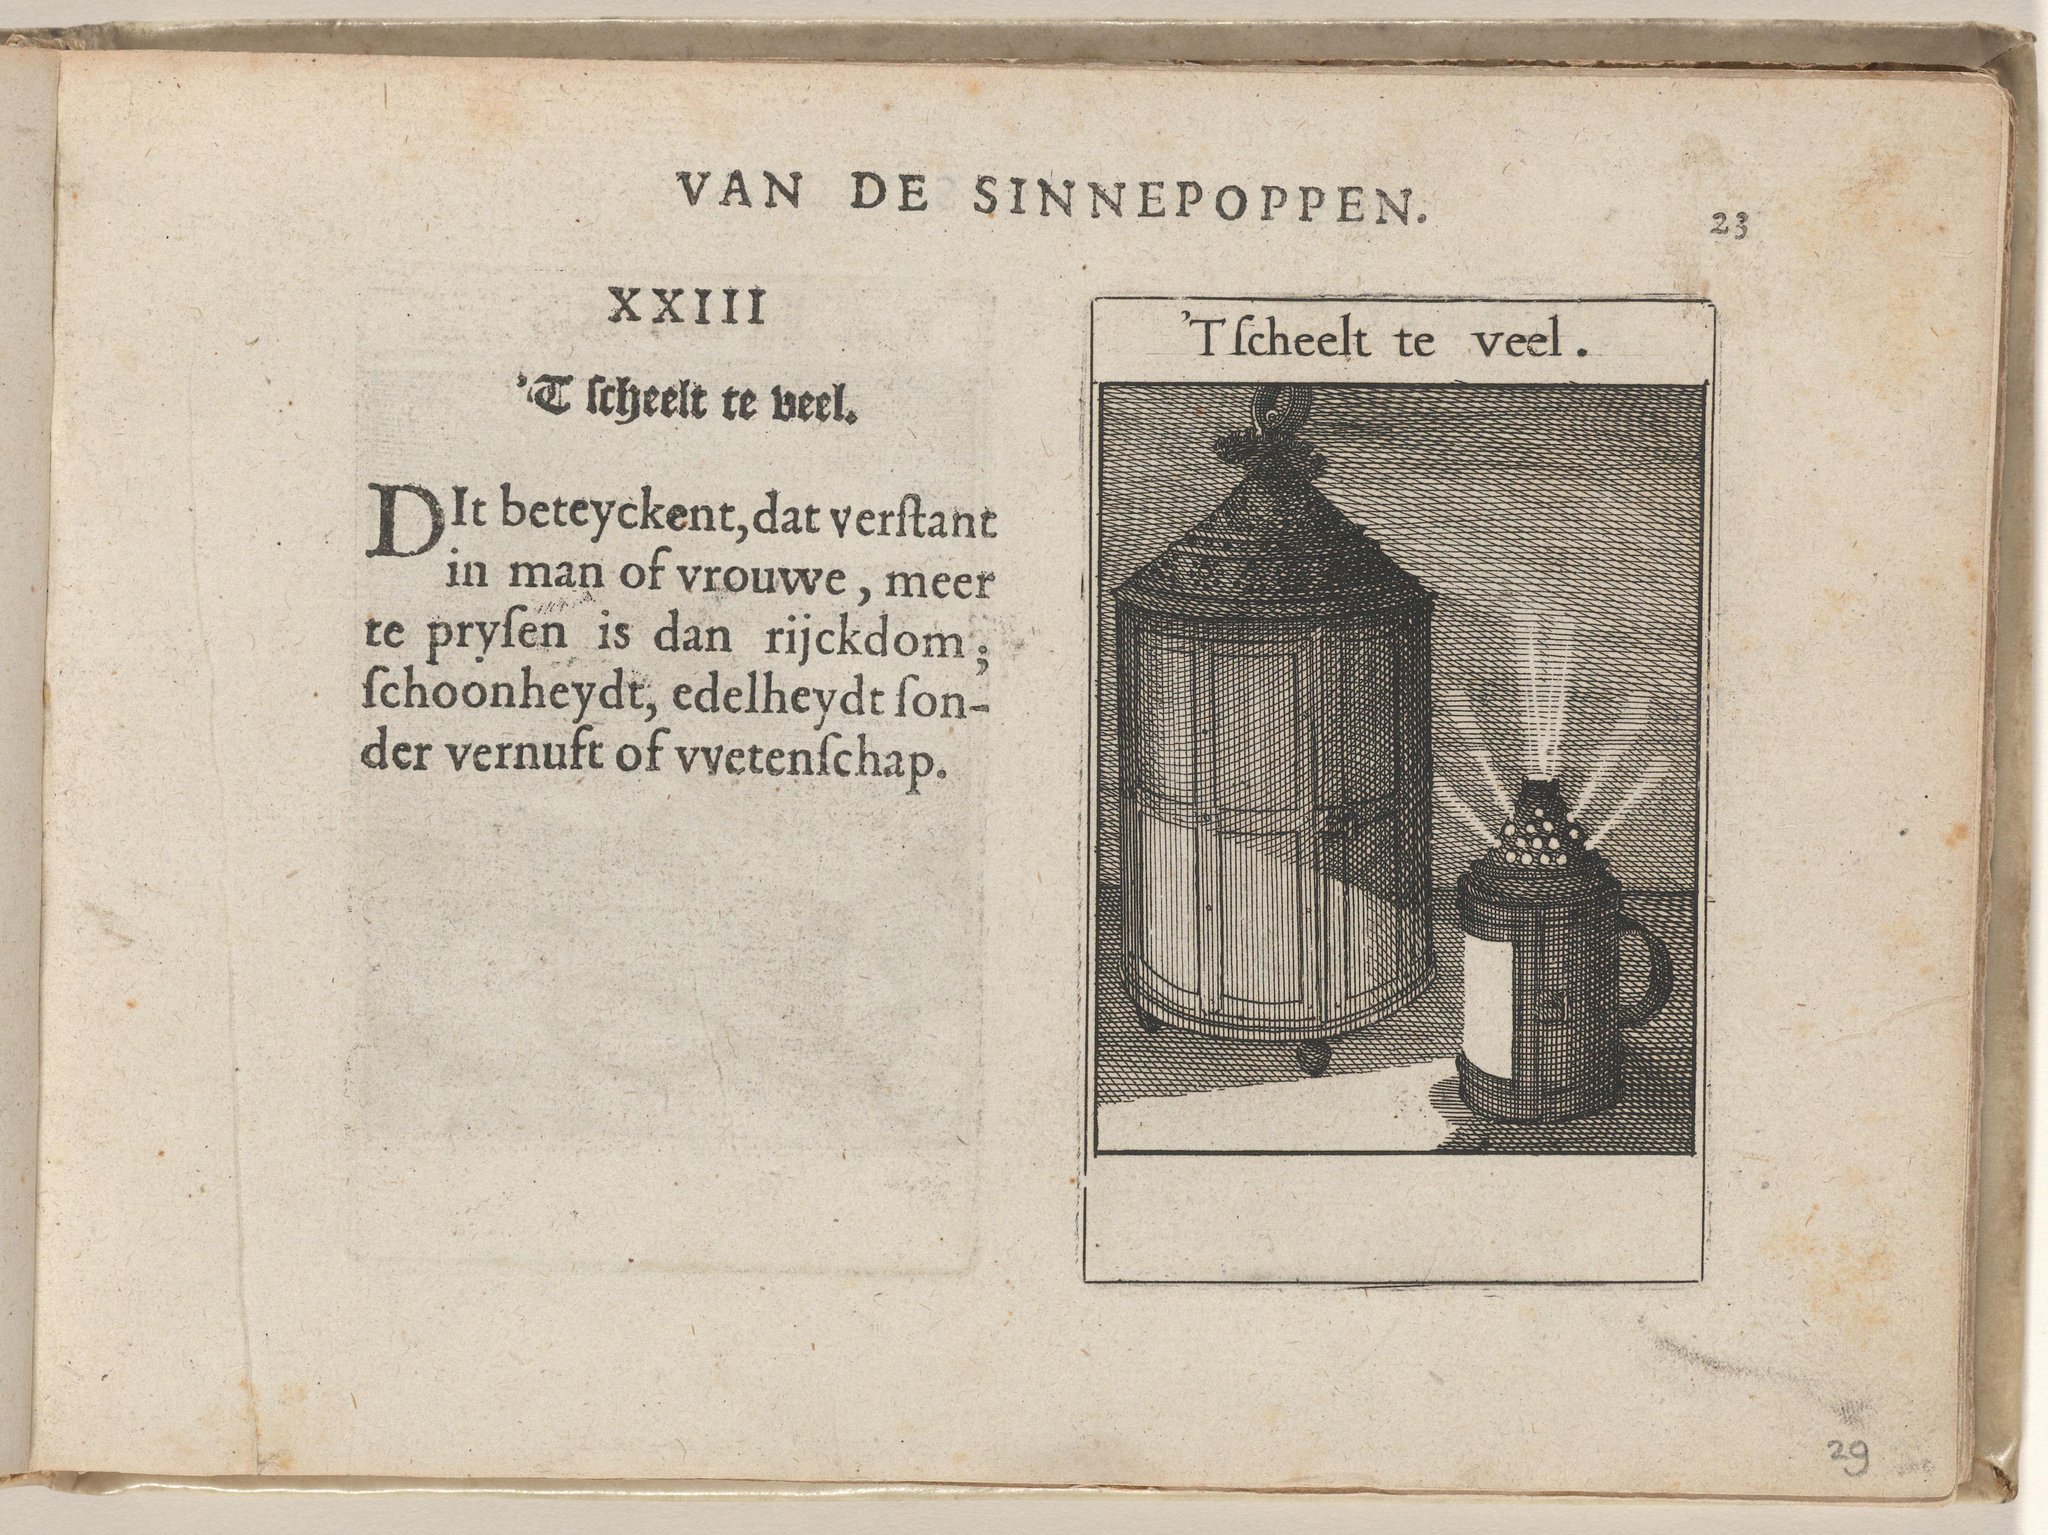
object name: album leaf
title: XXIII 'T scheelt te veel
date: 1614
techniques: engraving, printing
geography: amsterdam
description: XXIII 'T scheelt te veel. Eerste schok. Onderdeel van 'Sinnepoppen', R. Visscher, 1614.